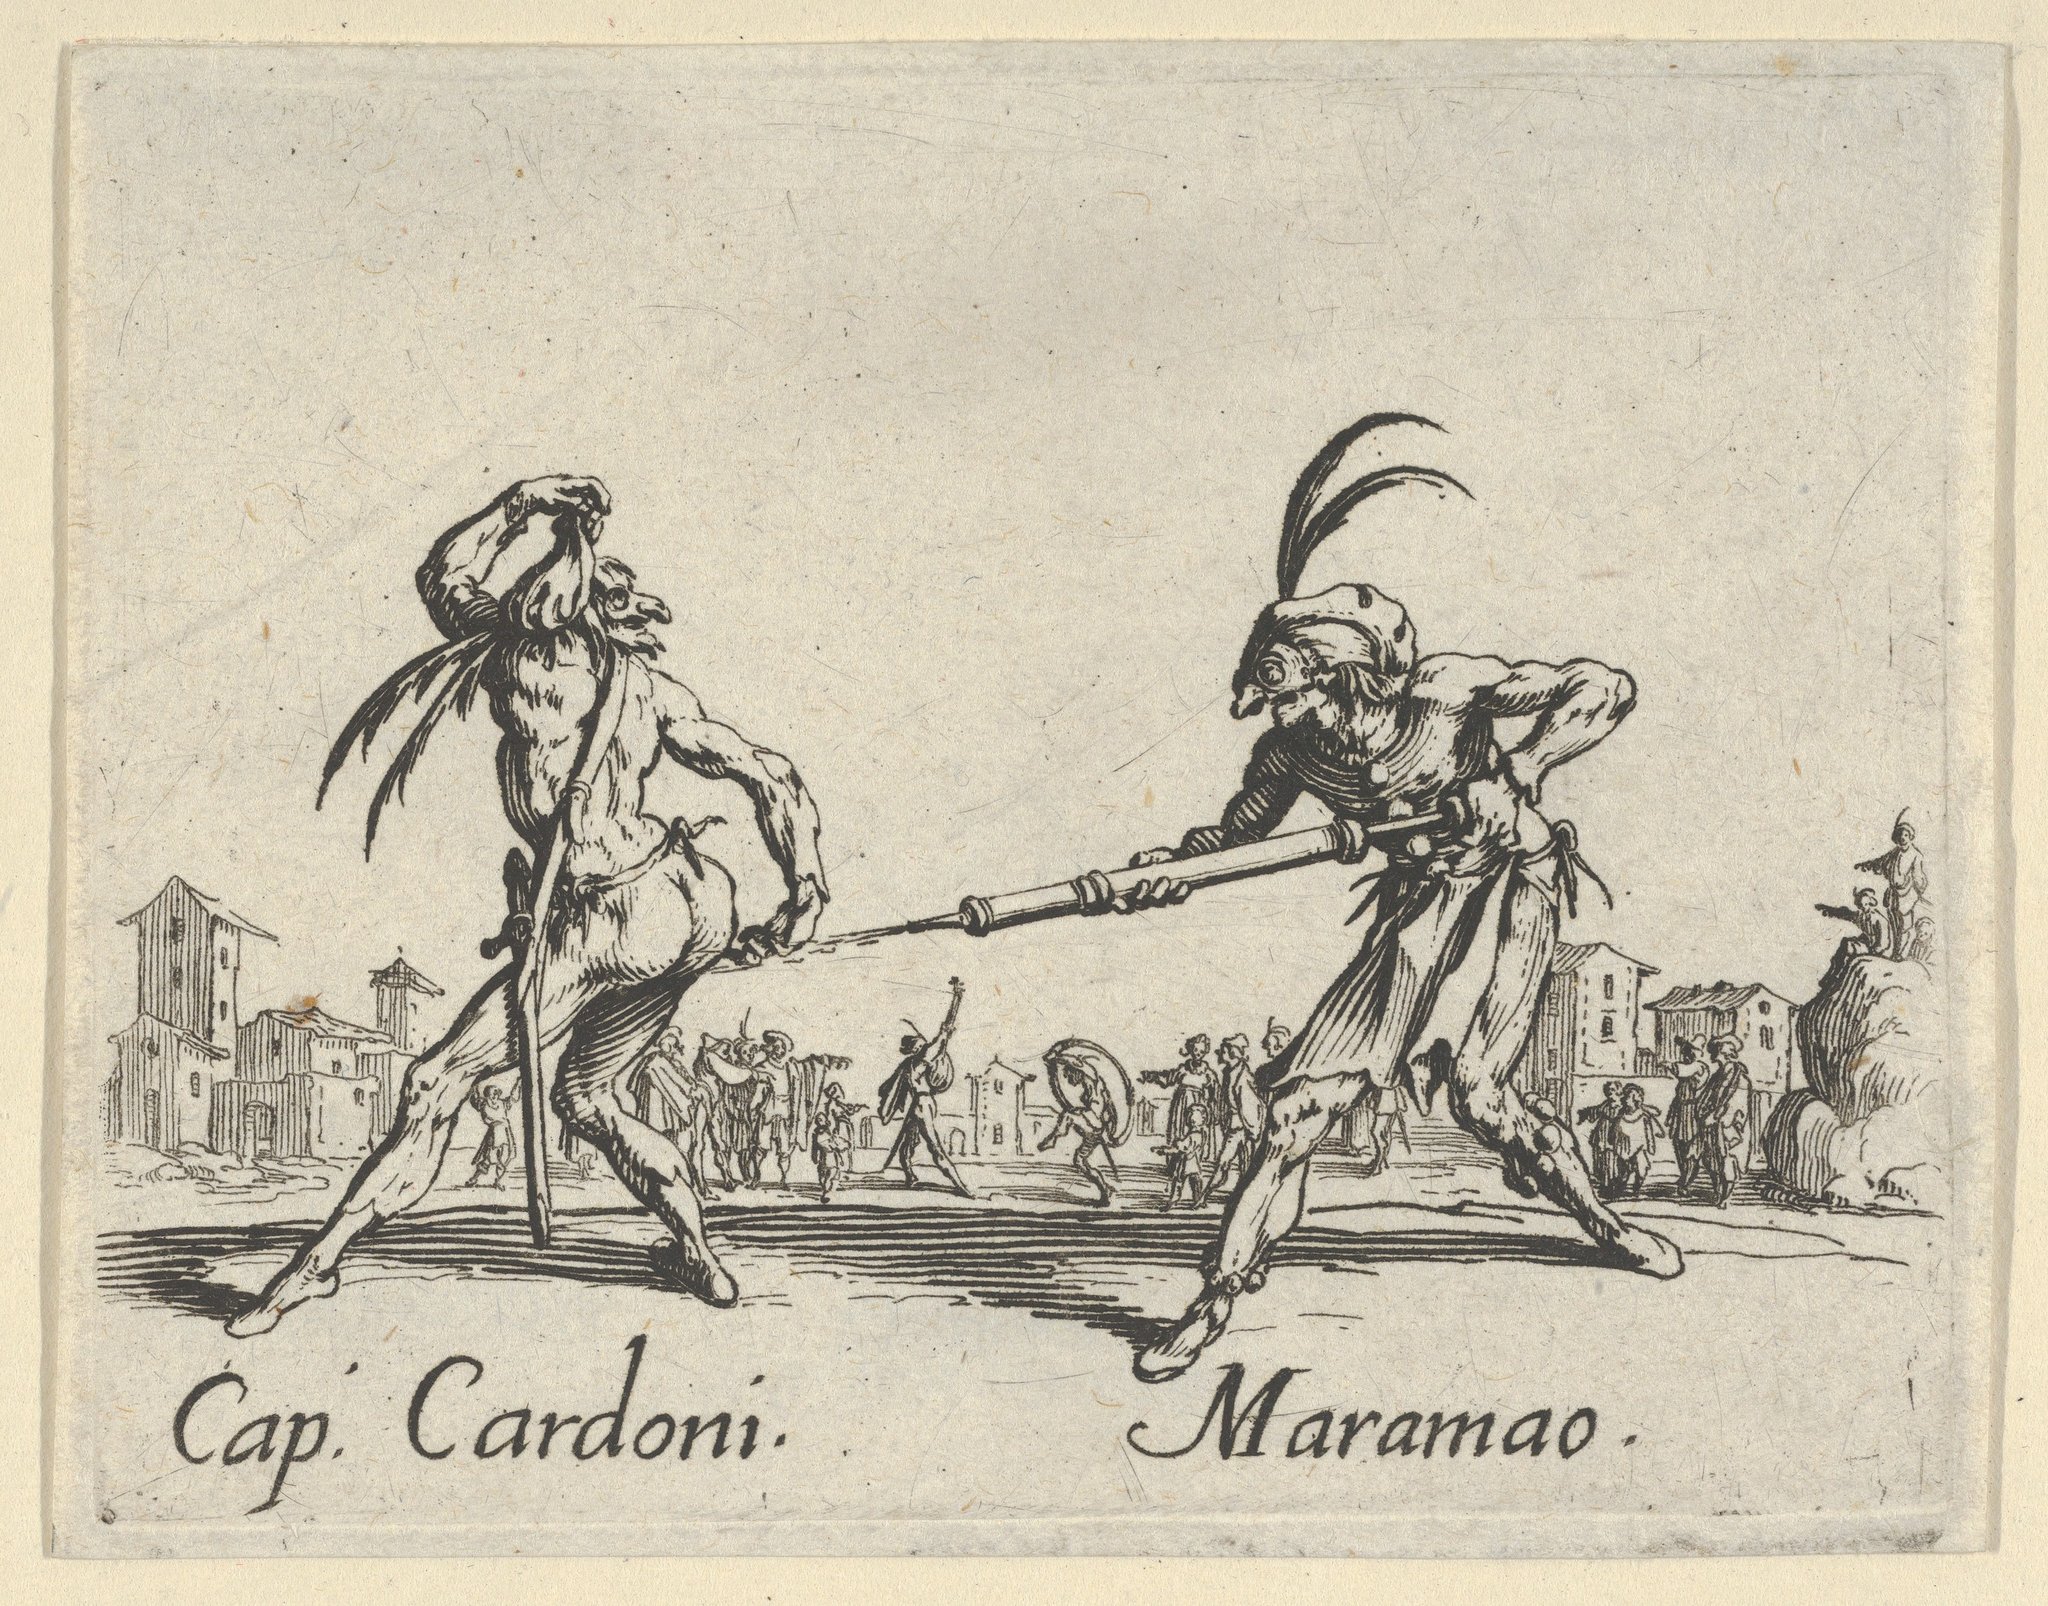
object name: print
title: Cap. Cardoni - Maramao, from "Balli di Sfessania" (Dance of Sfessania)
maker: jacques callot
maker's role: artist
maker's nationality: french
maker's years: 1592-1635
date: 1622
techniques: etching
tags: satire